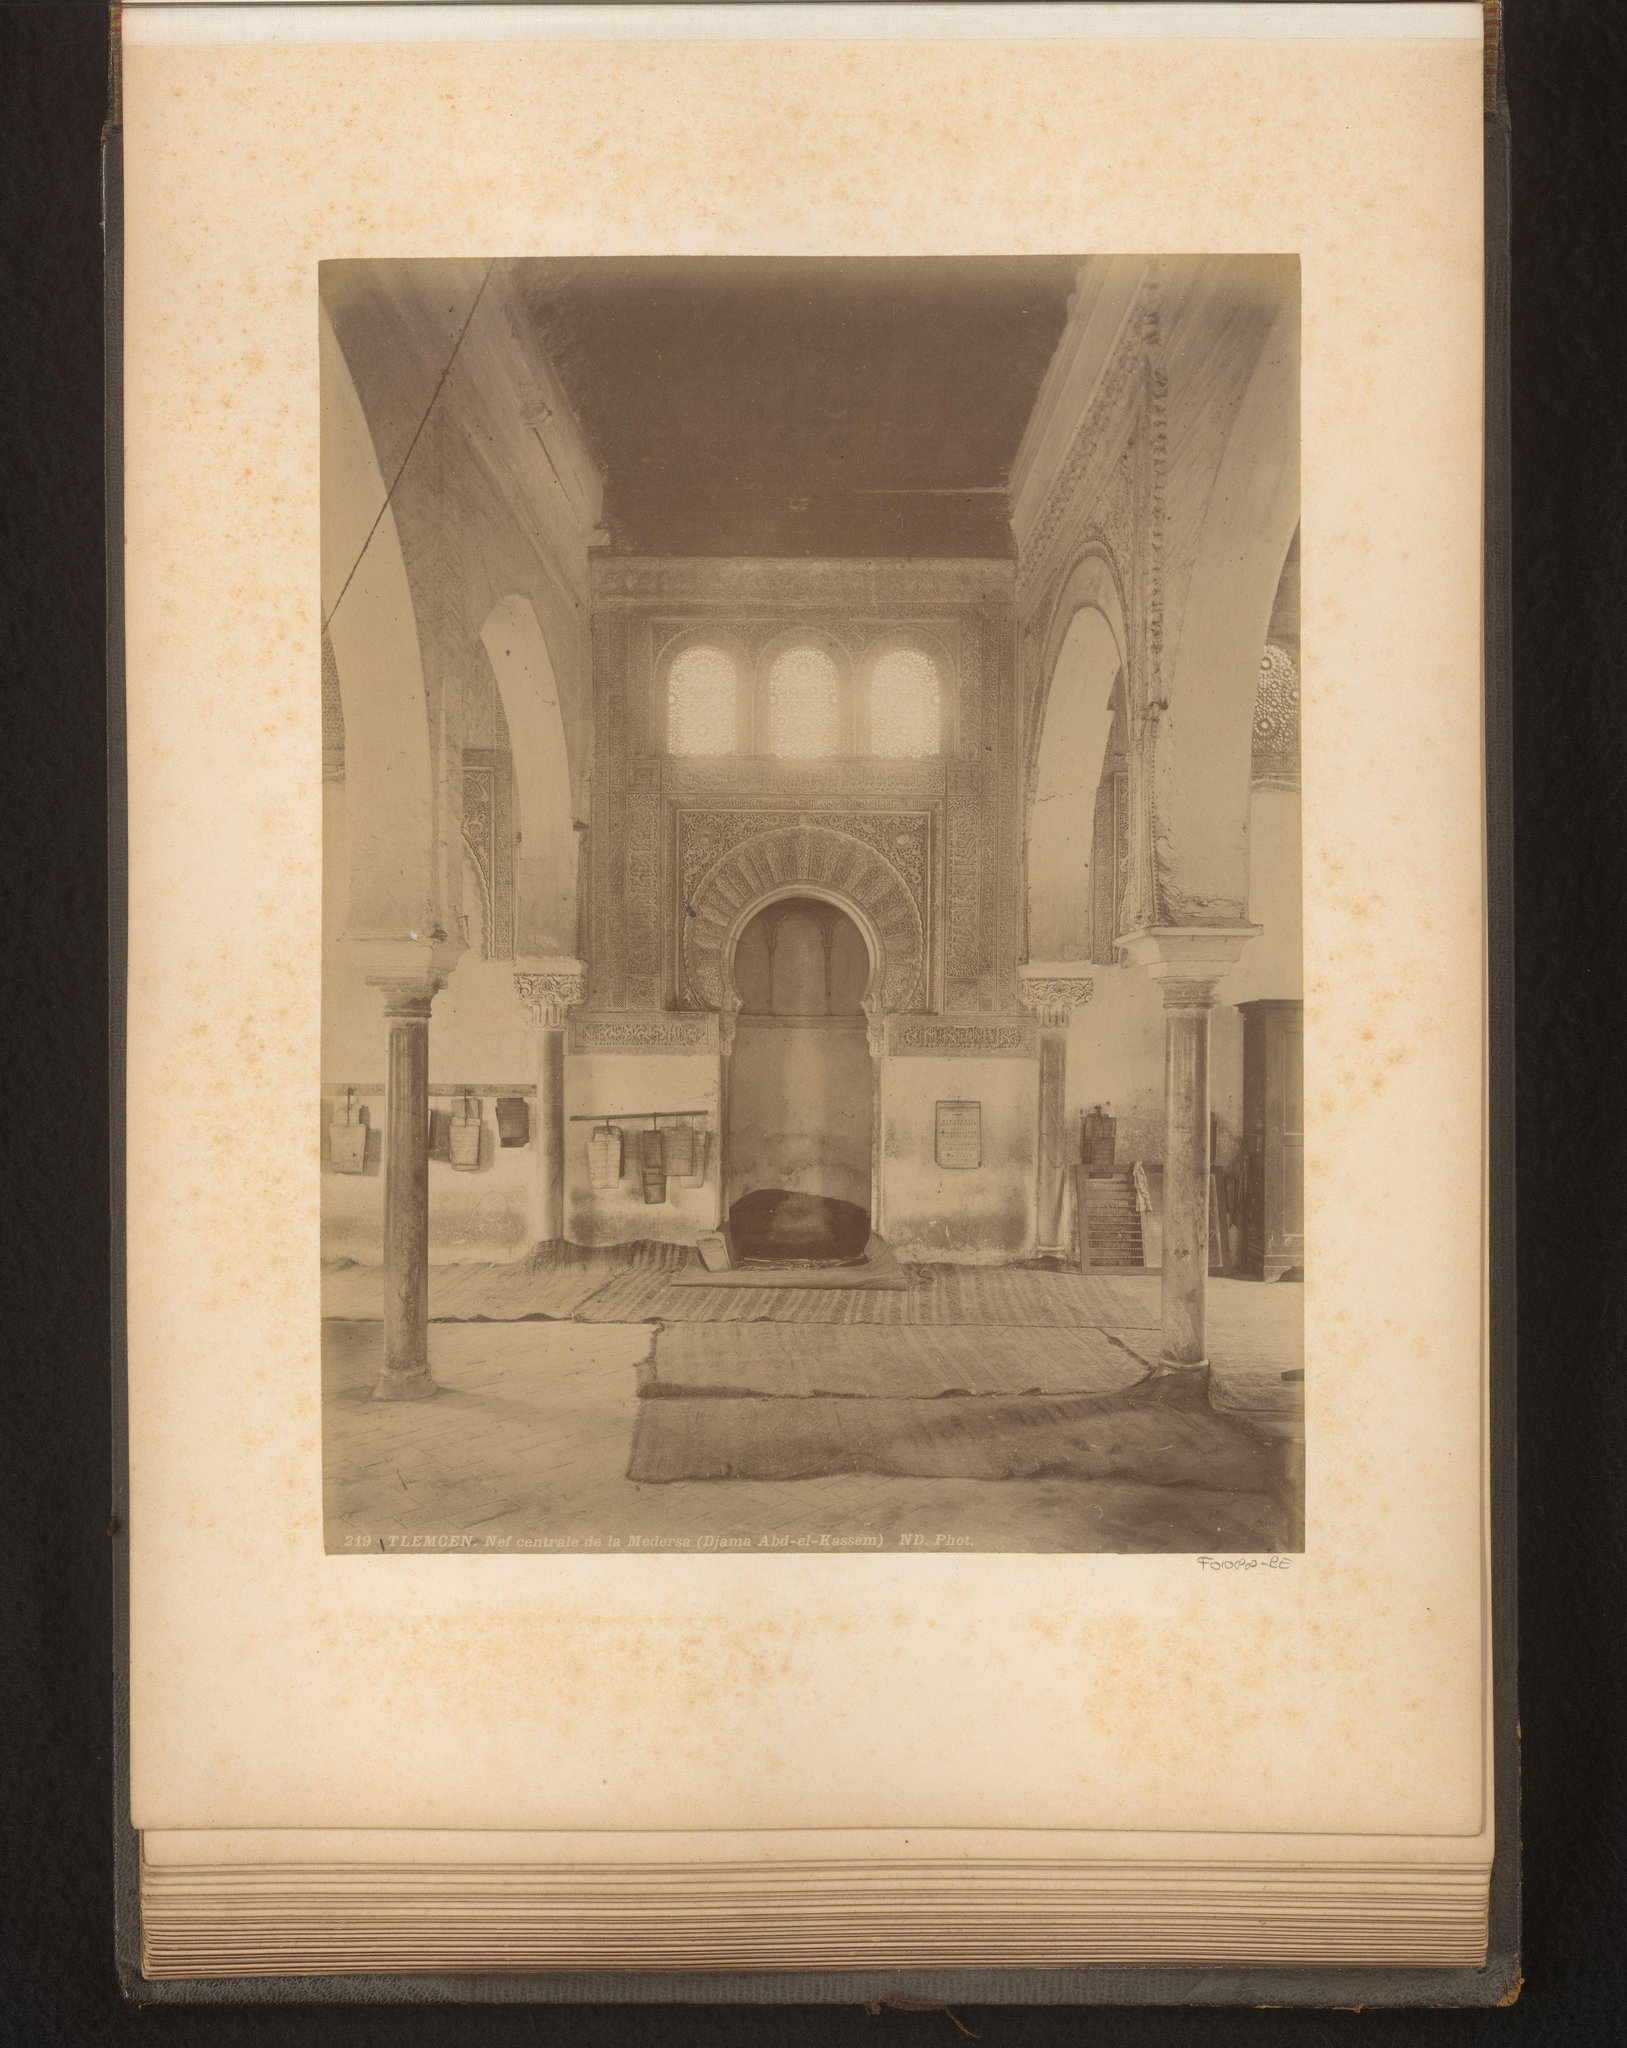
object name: photograph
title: Tlemcen. Nef centrale de la Medersa (Djama Abd-el-Kassem)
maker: étienne neurdein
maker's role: publisher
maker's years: 1832-1918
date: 1880-1900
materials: photographic support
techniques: albumen print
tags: column, pillar ~ architecture, temple, shrine ~ islam, mohammedanism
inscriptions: number: ‘219’